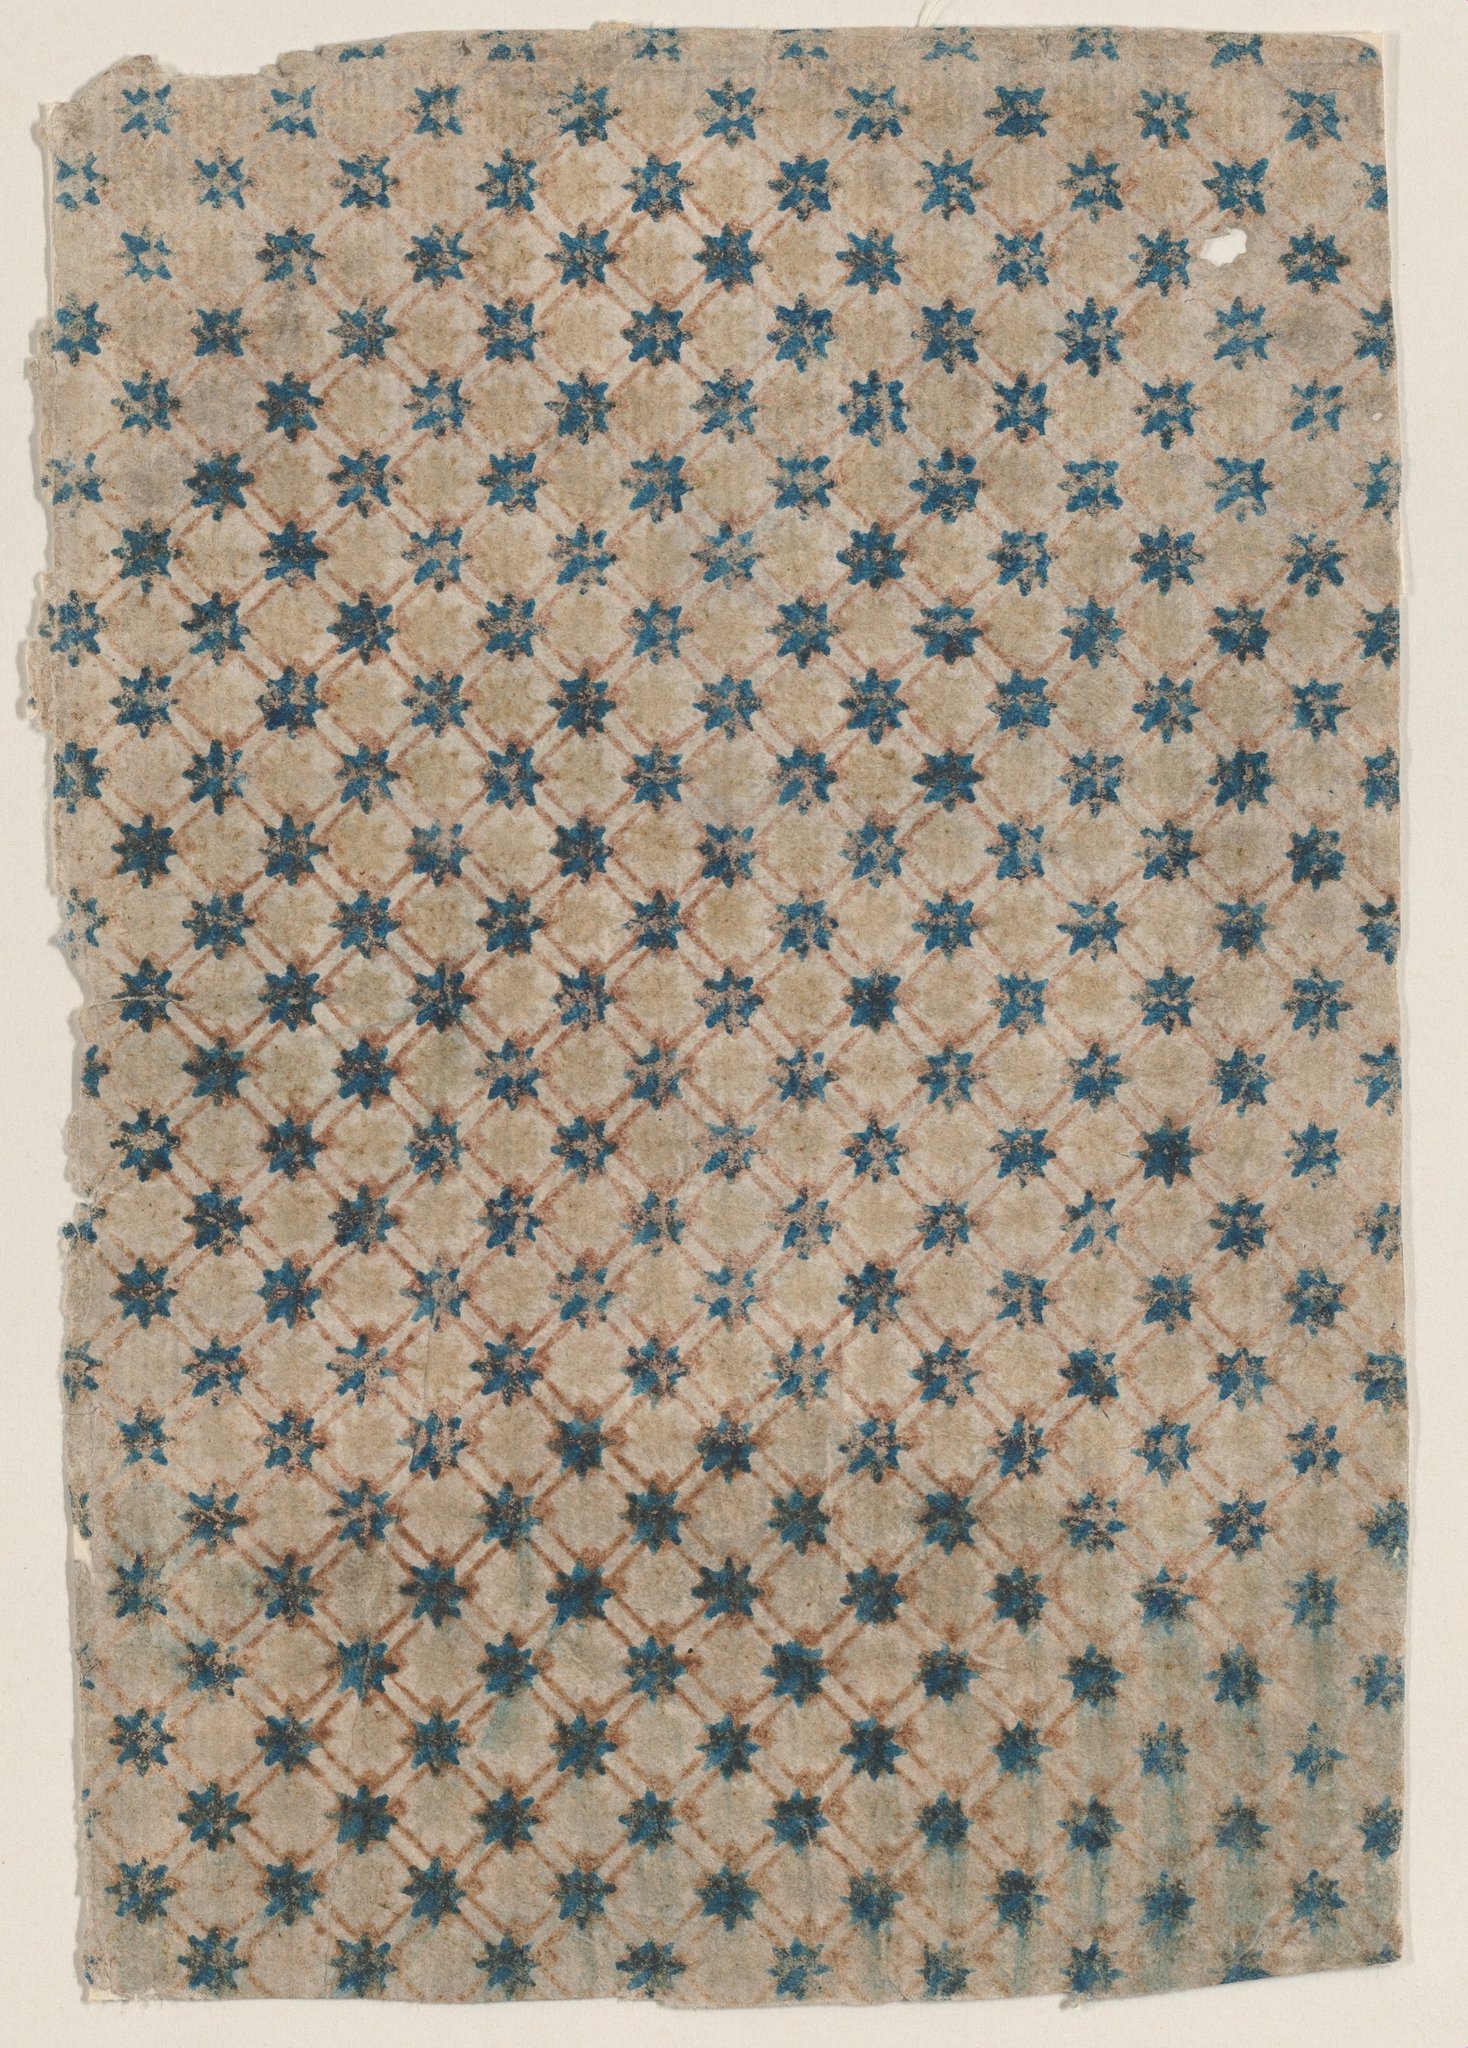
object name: print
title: Sheet with overall grid pattern with stars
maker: Anonymous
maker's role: artist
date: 1801-1900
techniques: relief print